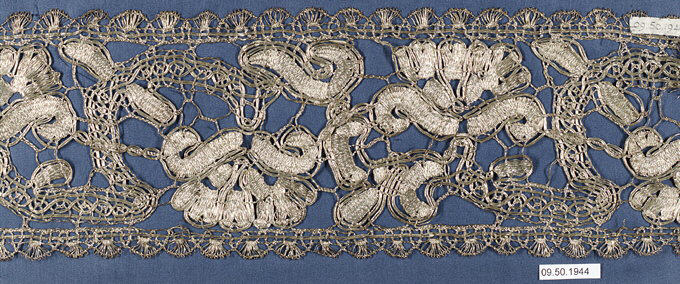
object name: strip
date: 1601-1700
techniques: lace